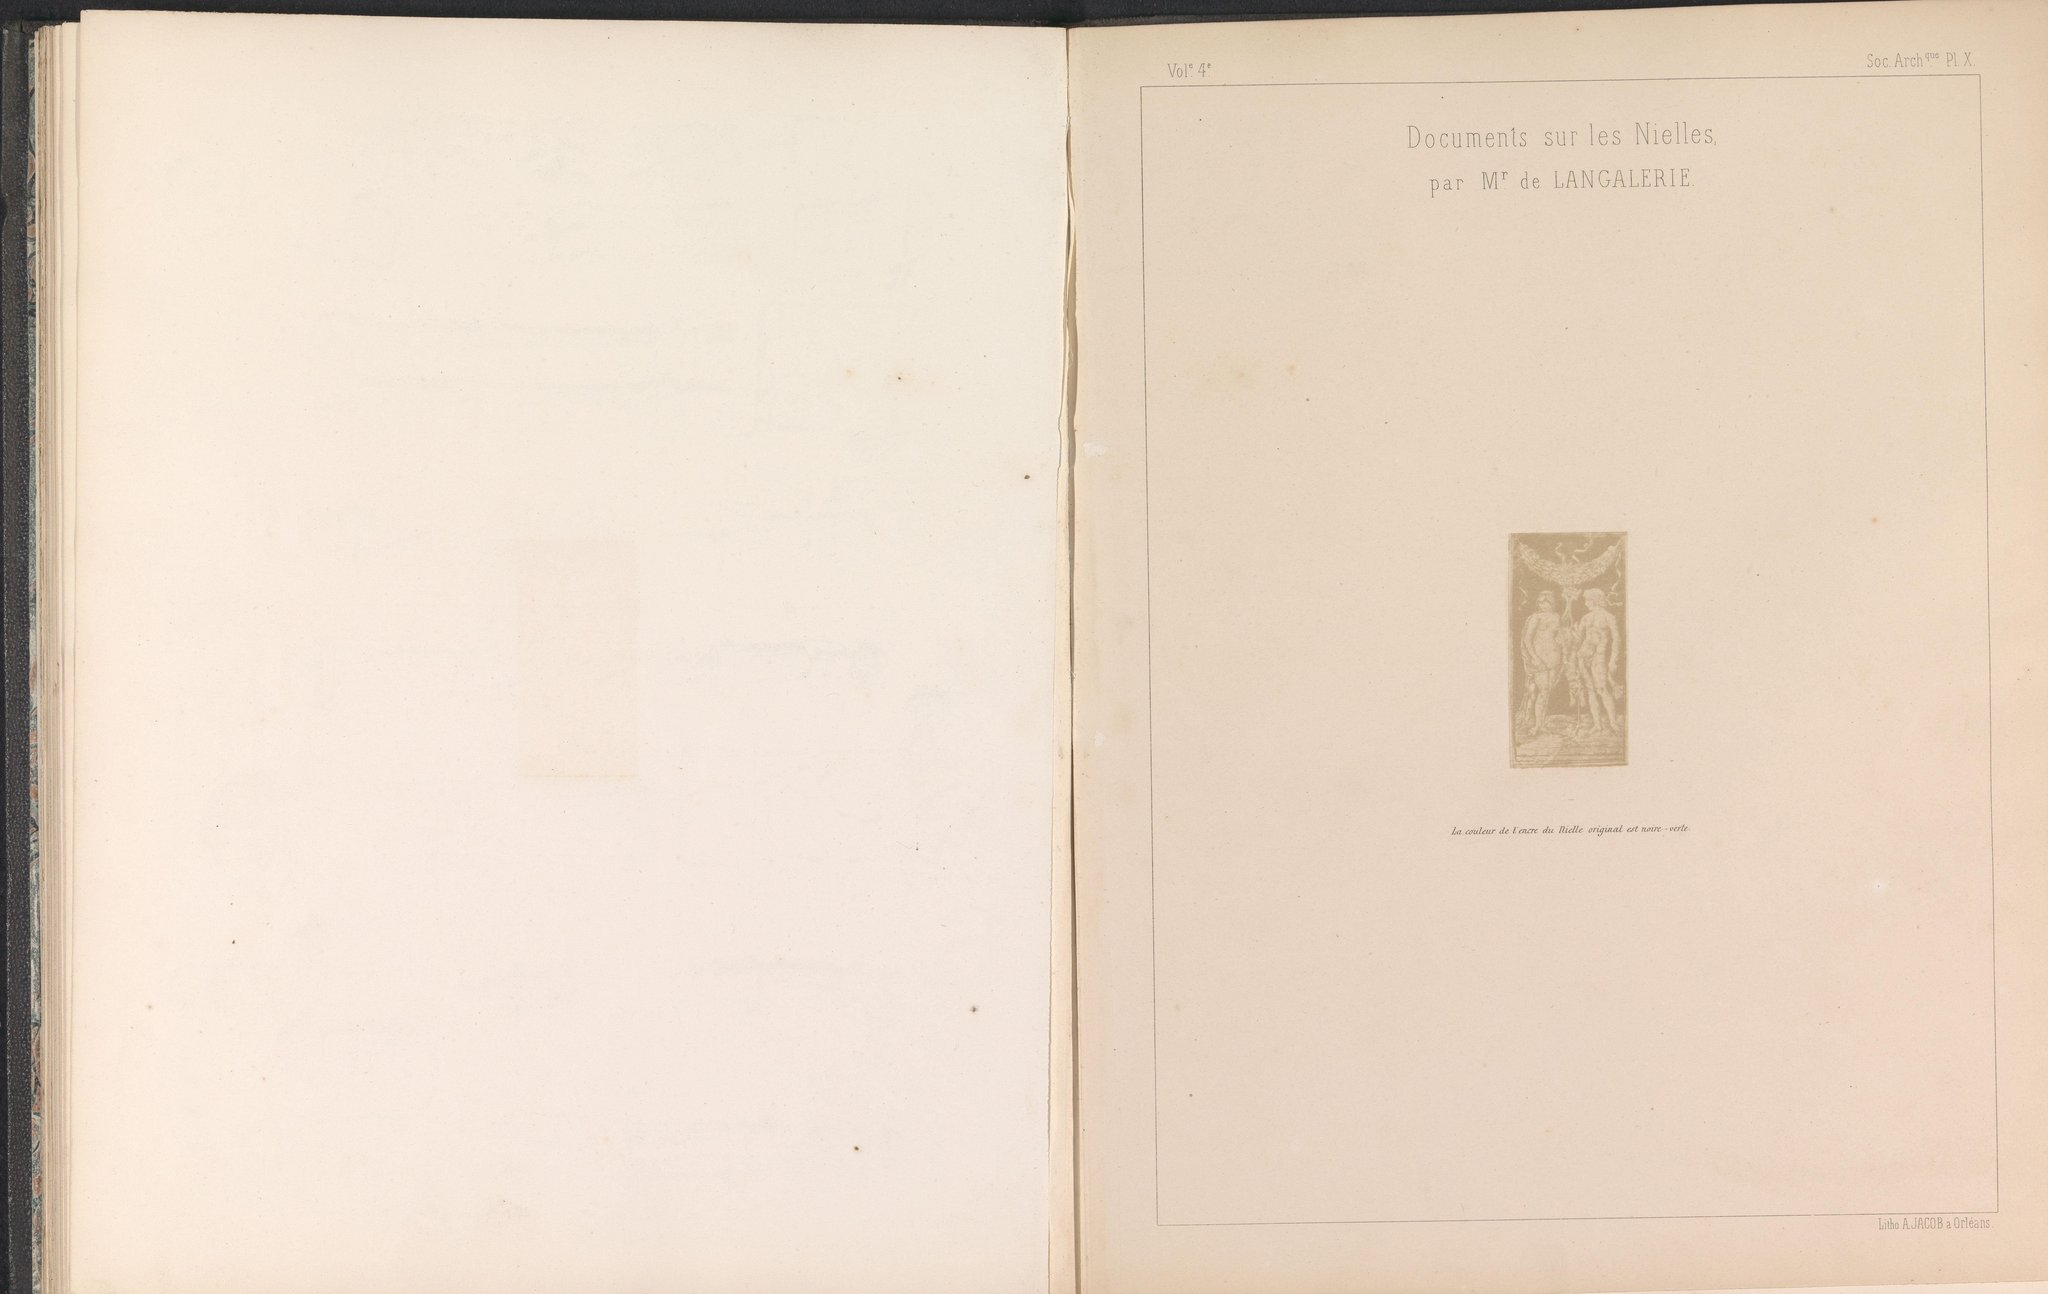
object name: page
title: Fotoreproductie van een niello met een man en een vrouw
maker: Anonymous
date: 1850-1858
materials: photographic support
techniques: salted paper print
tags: damascening, niello-ing ~ applied arts, couple of lovers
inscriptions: inscription: ‘La couleur de l'encre du Nielle original est noire-verte.’, number: ‘Pl. X.’